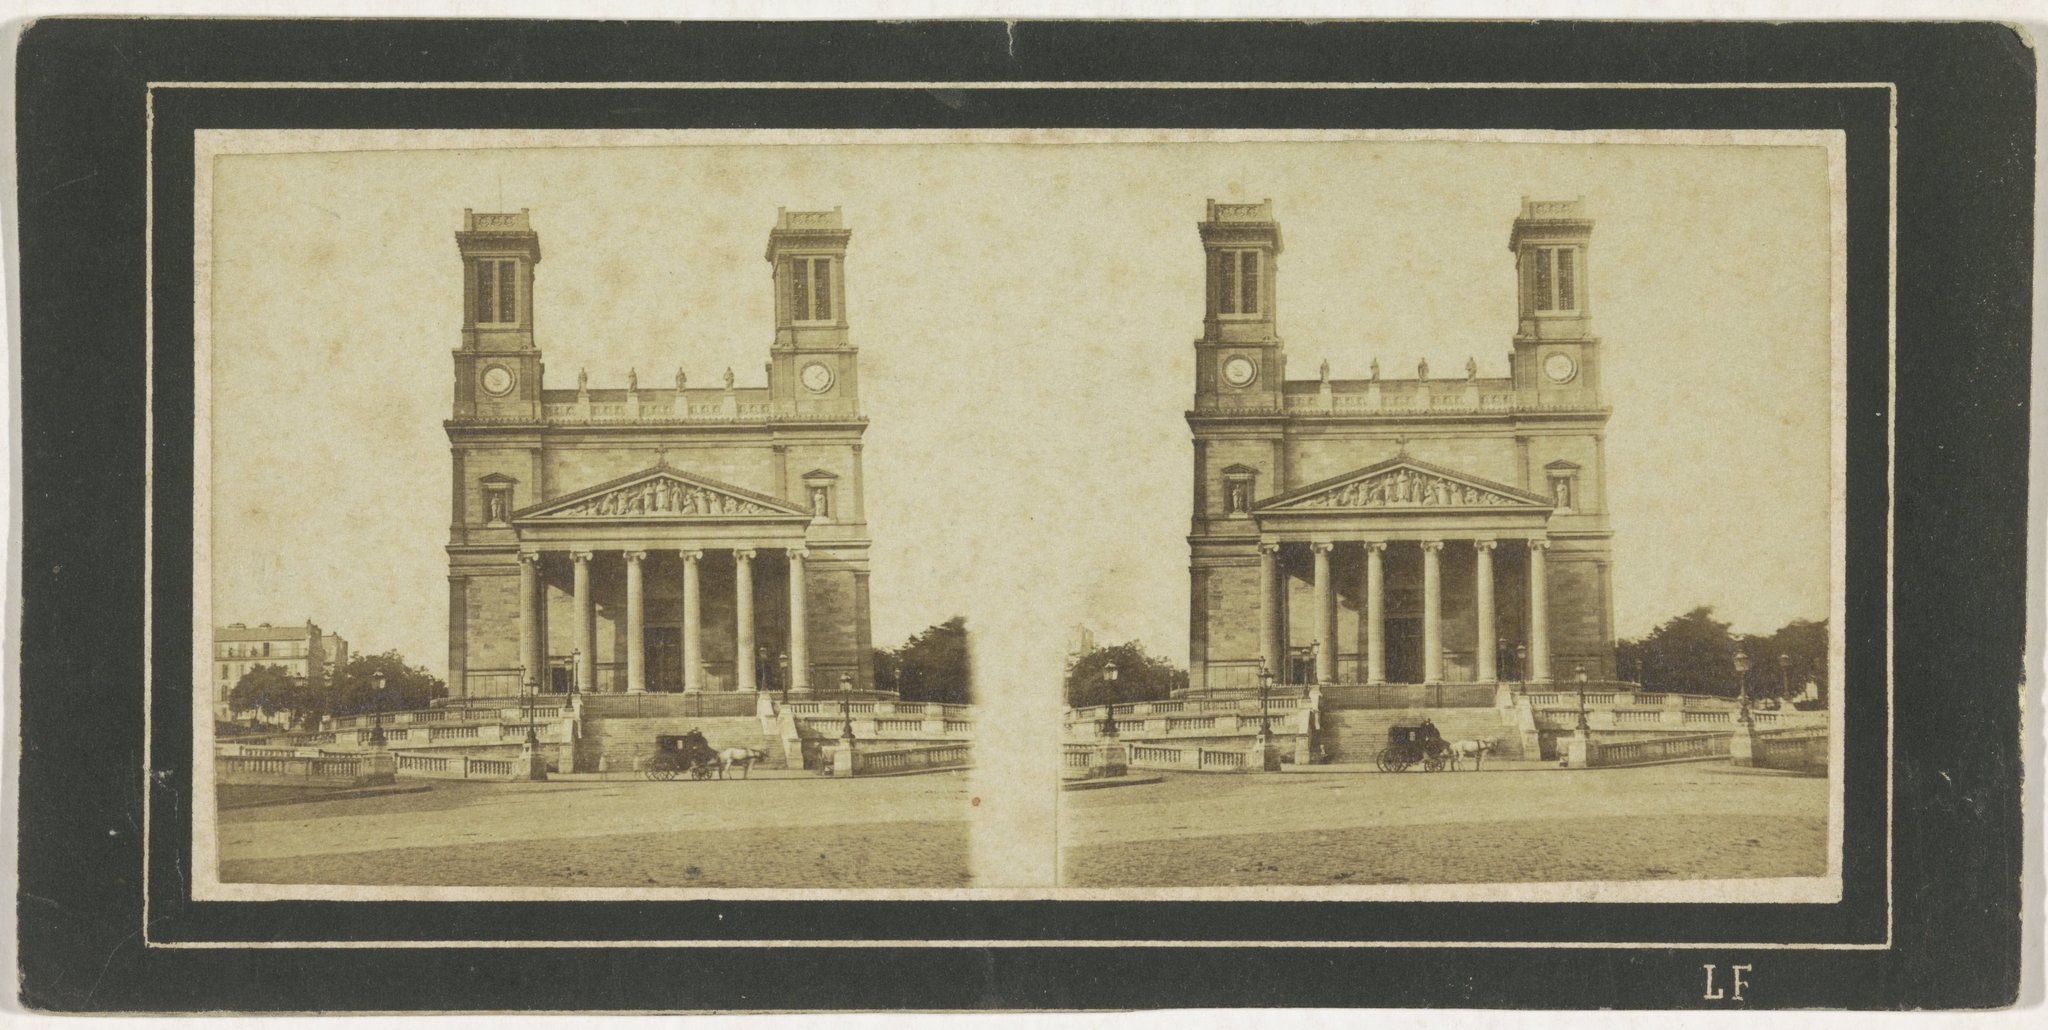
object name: stereograph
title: Église Saint-Vincent-de-Paul te Parijs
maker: lf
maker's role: fotograaf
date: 1850-1880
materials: cardboard, paper, photographic support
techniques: albumen print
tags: paris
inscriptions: title: ‘No 2 / Eglise St Vincent de Paul à Paris’, inscription: ‘€7-’, inscription: ‘Nº 81521’